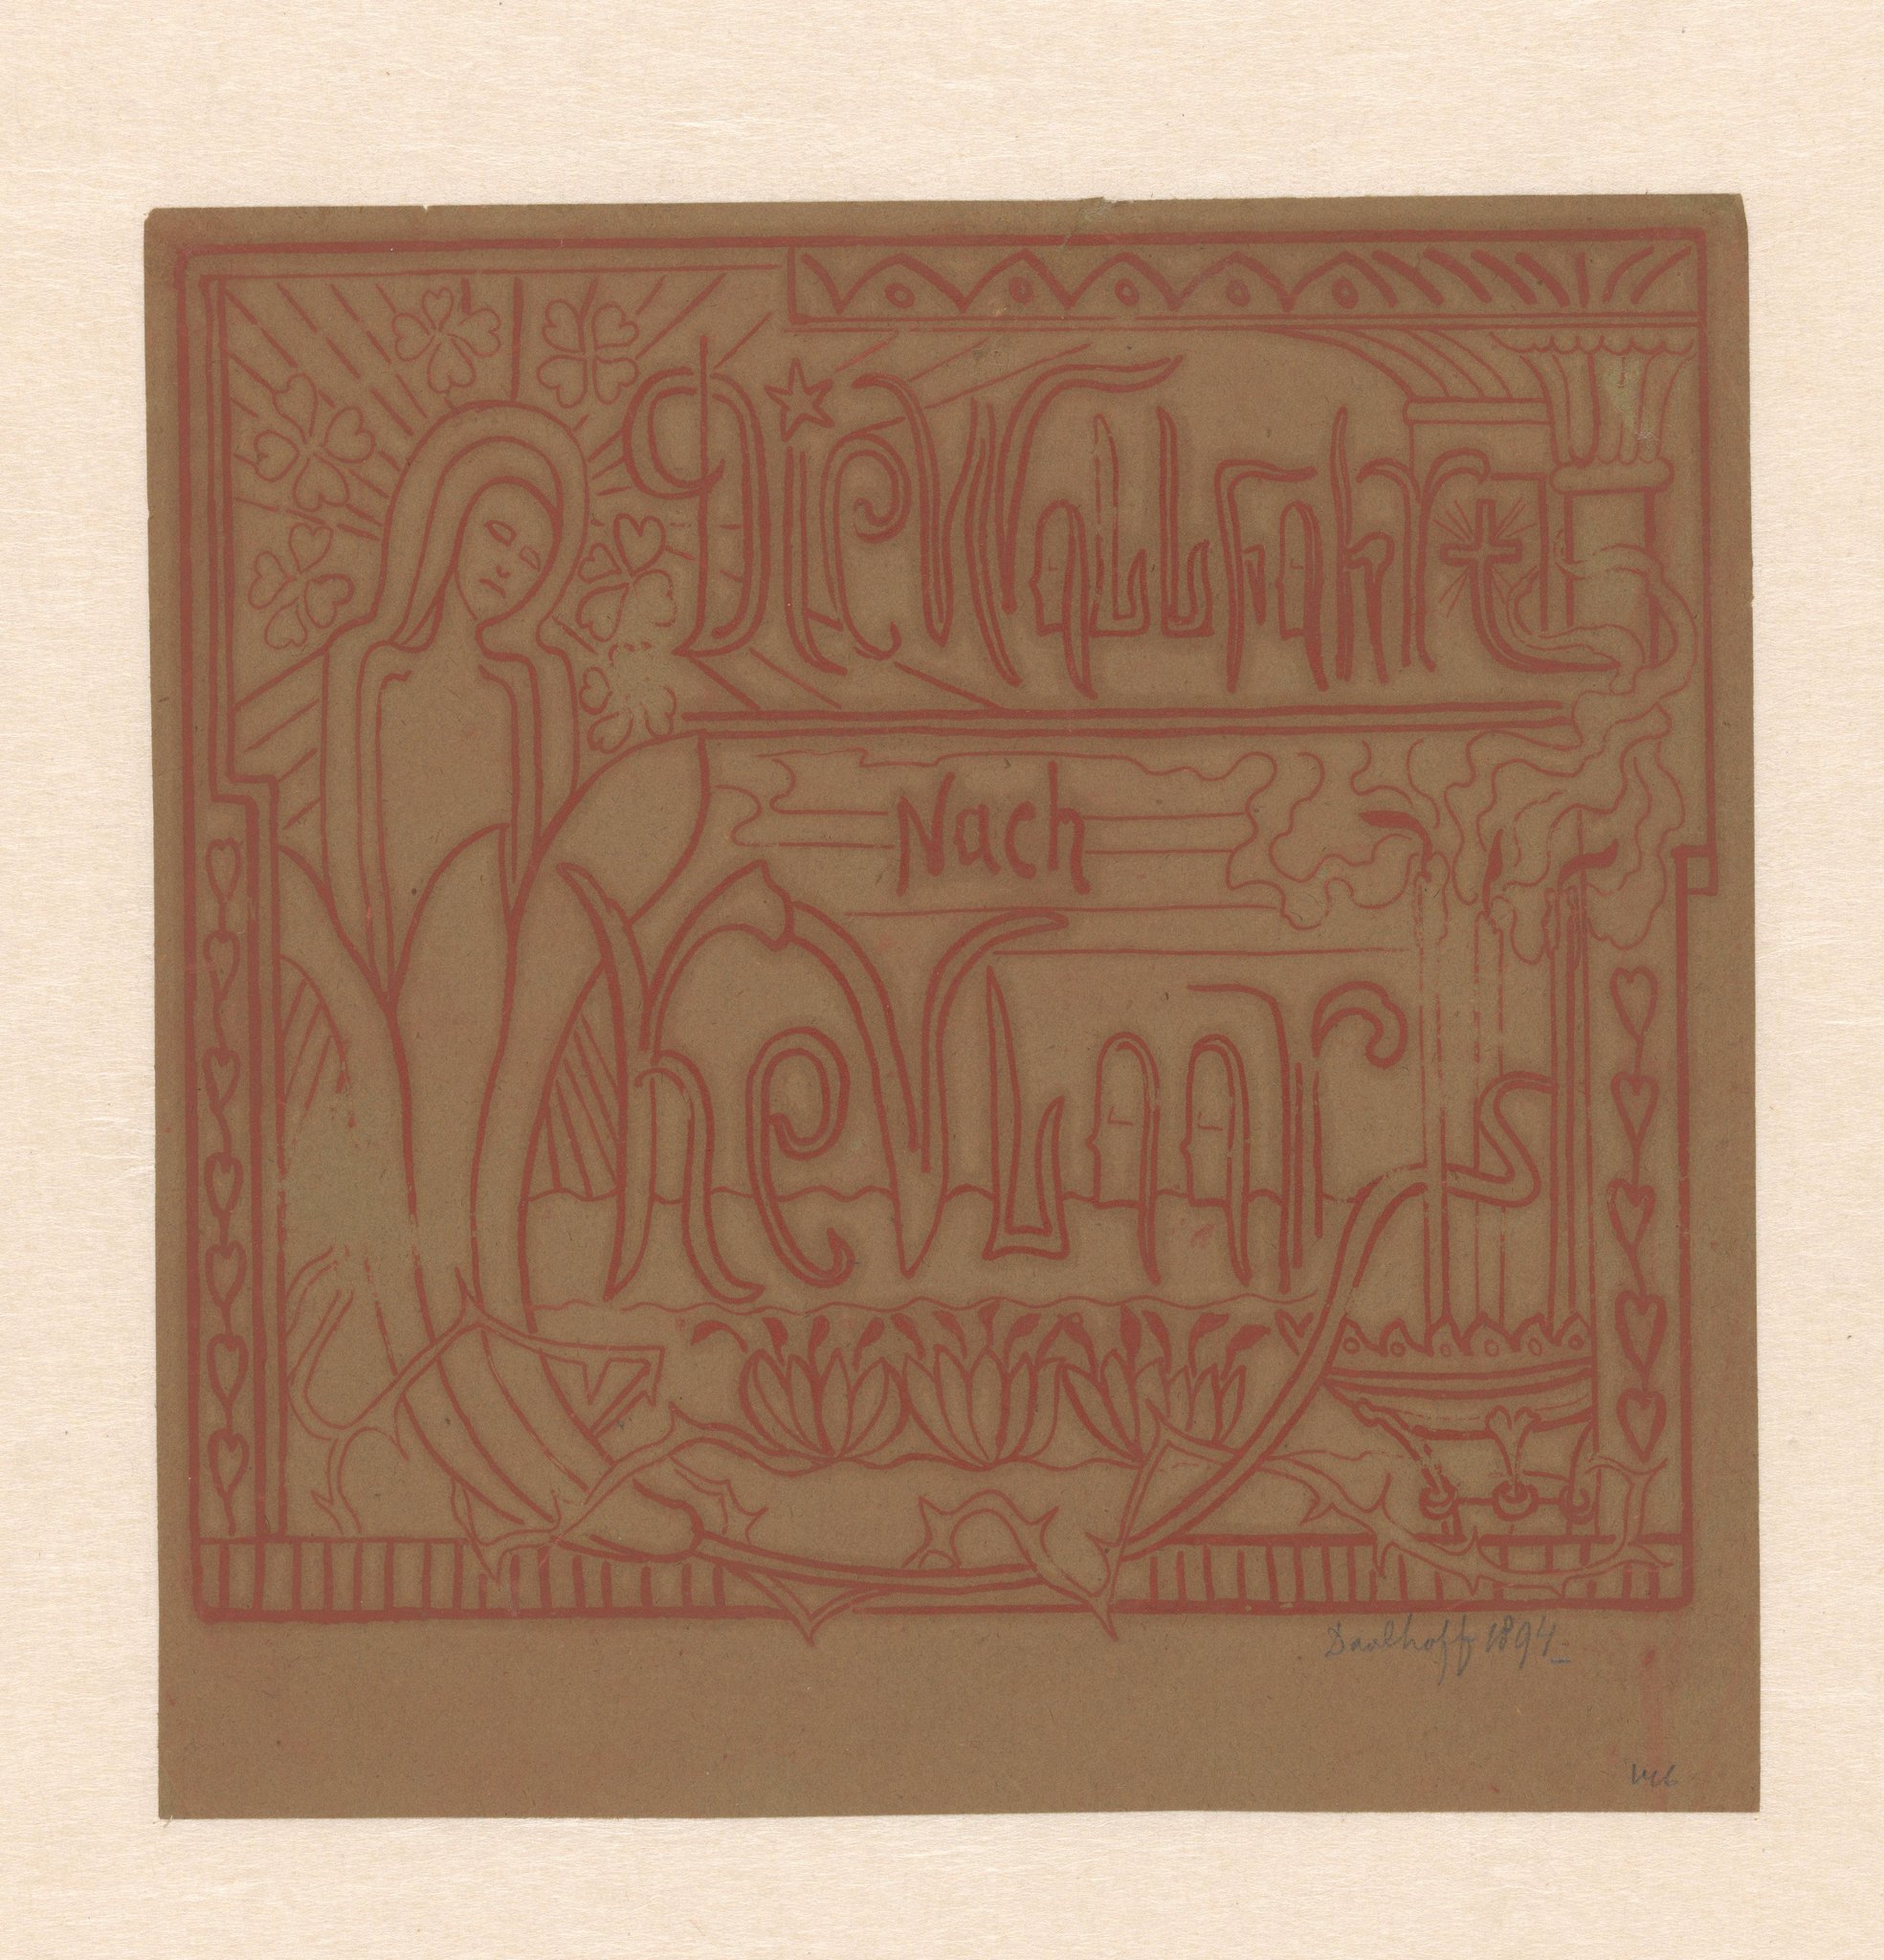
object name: print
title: Die Wallfahrt nach Kevlaar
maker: herman antonius van daalhoff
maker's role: draughtsman, print maker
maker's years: 1867-1953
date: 1894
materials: paper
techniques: etching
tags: paris, plants (in general), candle, standing figure - aa - female human figure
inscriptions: collector's mark: Lugt 2228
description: De tekst 'Die Wallfahrt nach Kevlaar' in sierletters, onder meer omgeven door een vrouwenfiguur, plantmotieven, kaarsen en architectonische elementen.